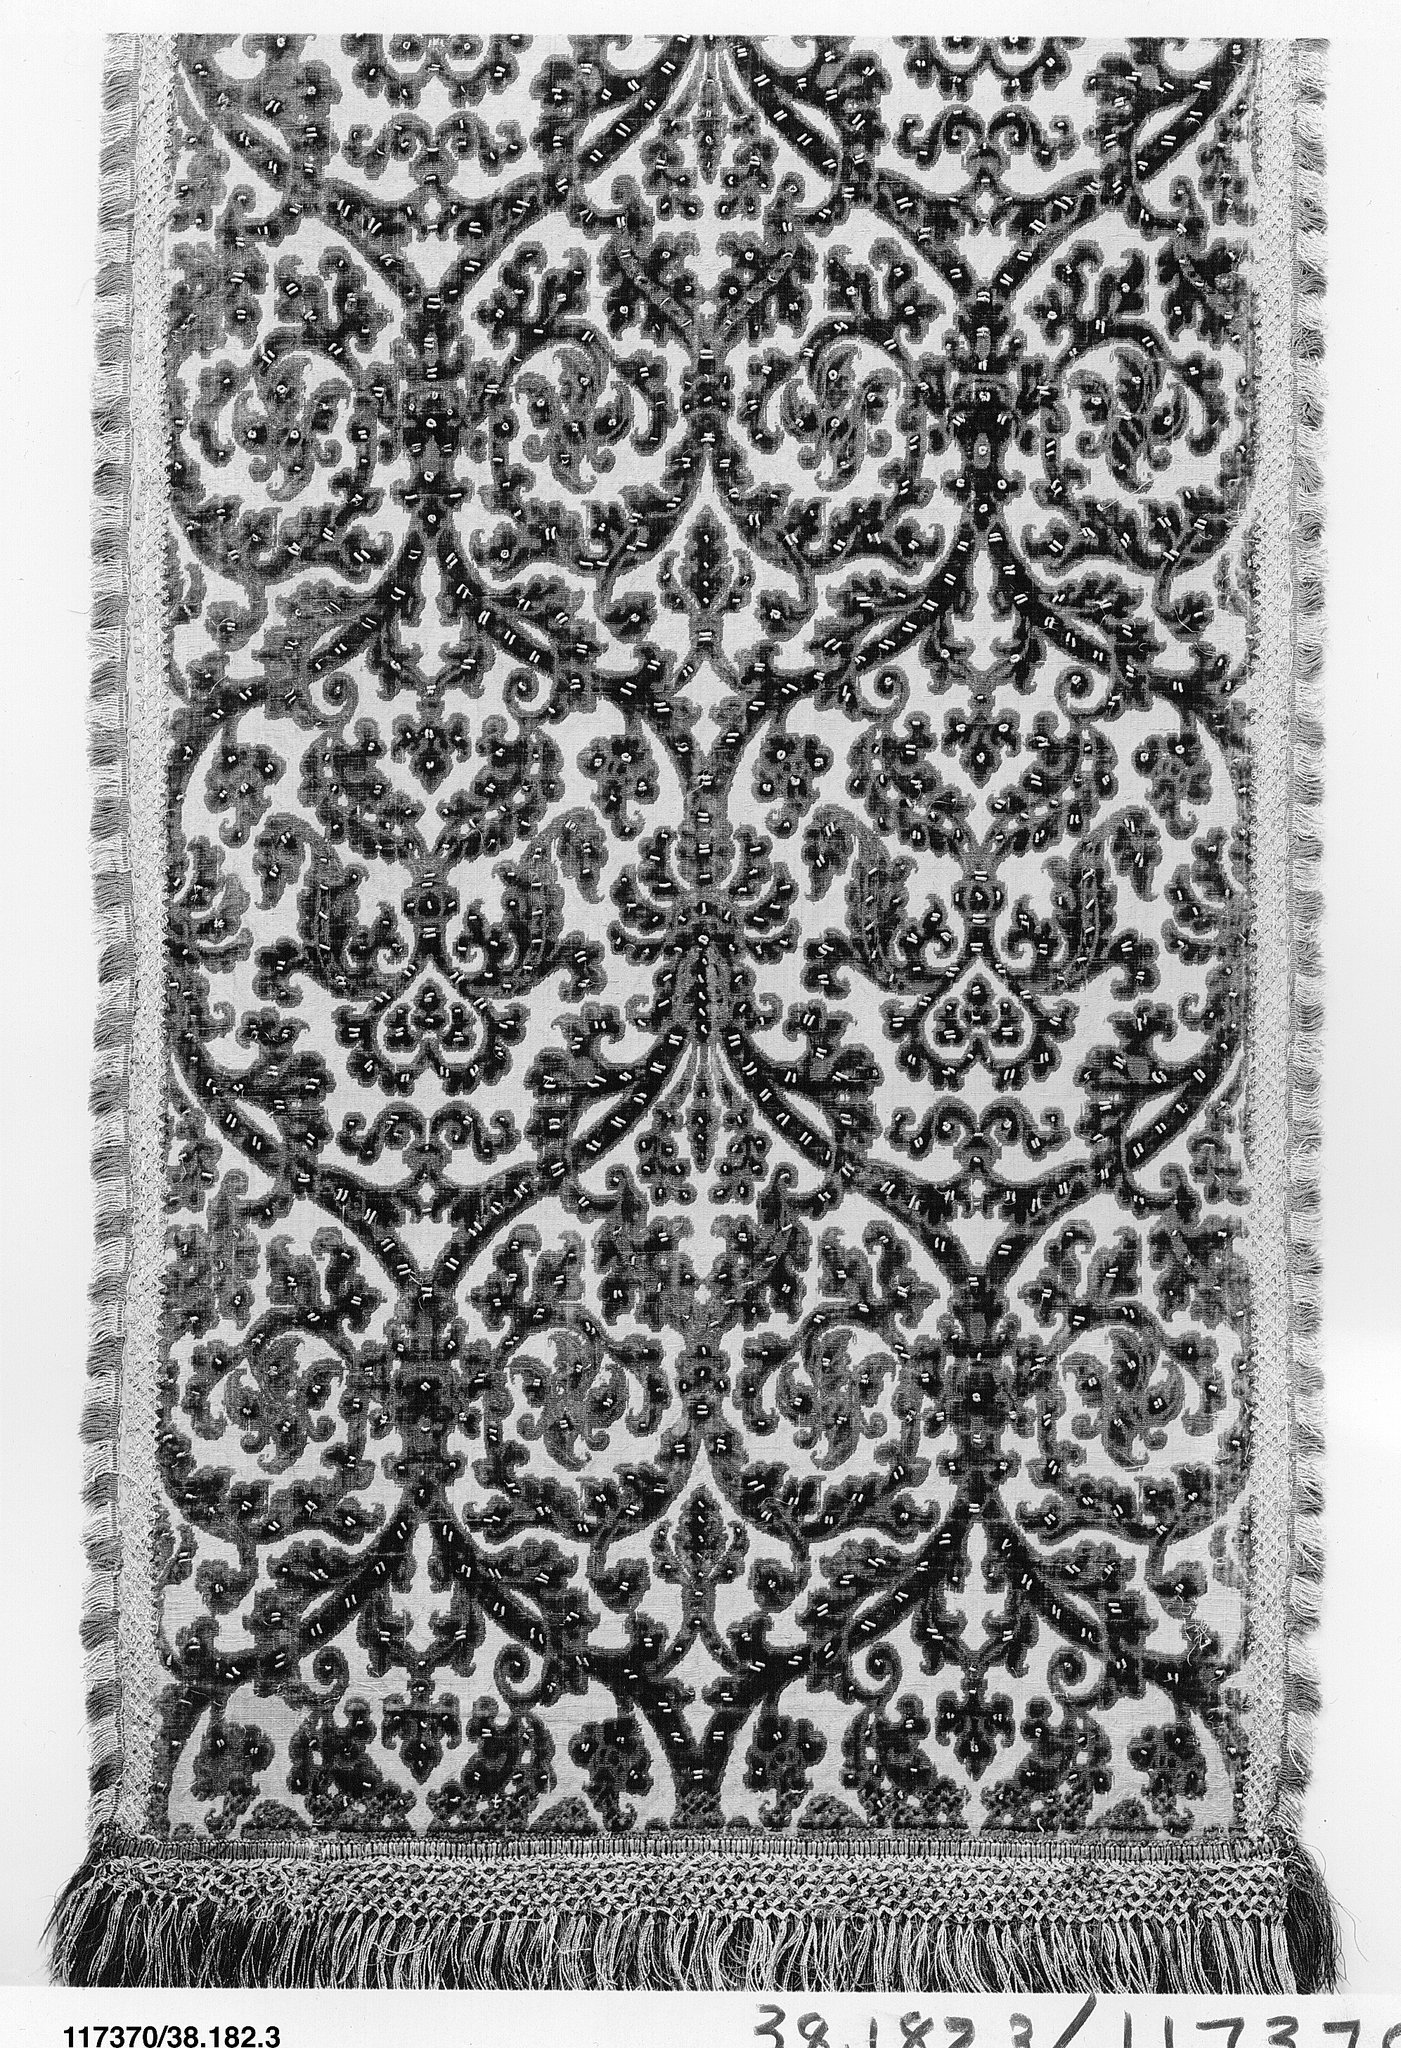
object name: piece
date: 1501-1600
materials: metal thread, silk